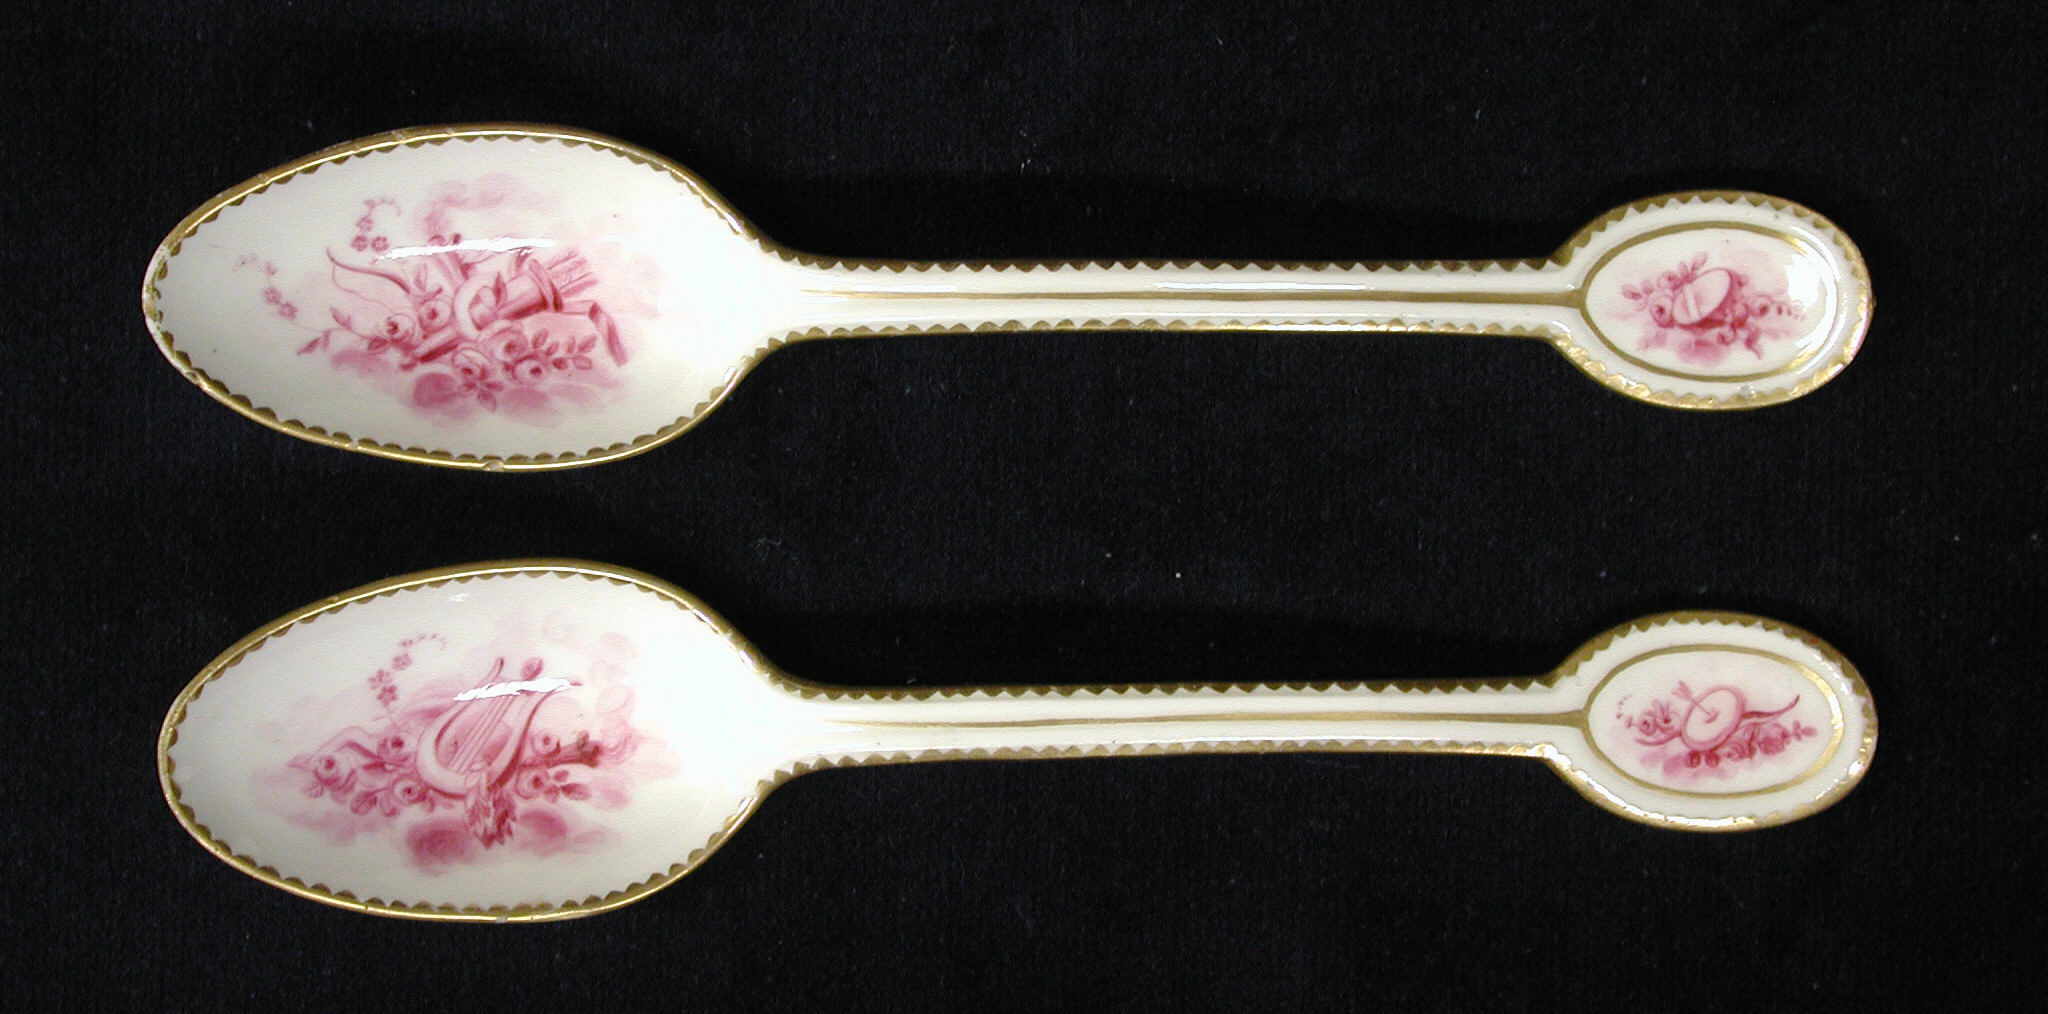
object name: tablespoon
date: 1701-1900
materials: soft paste porcelain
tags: musical instruments